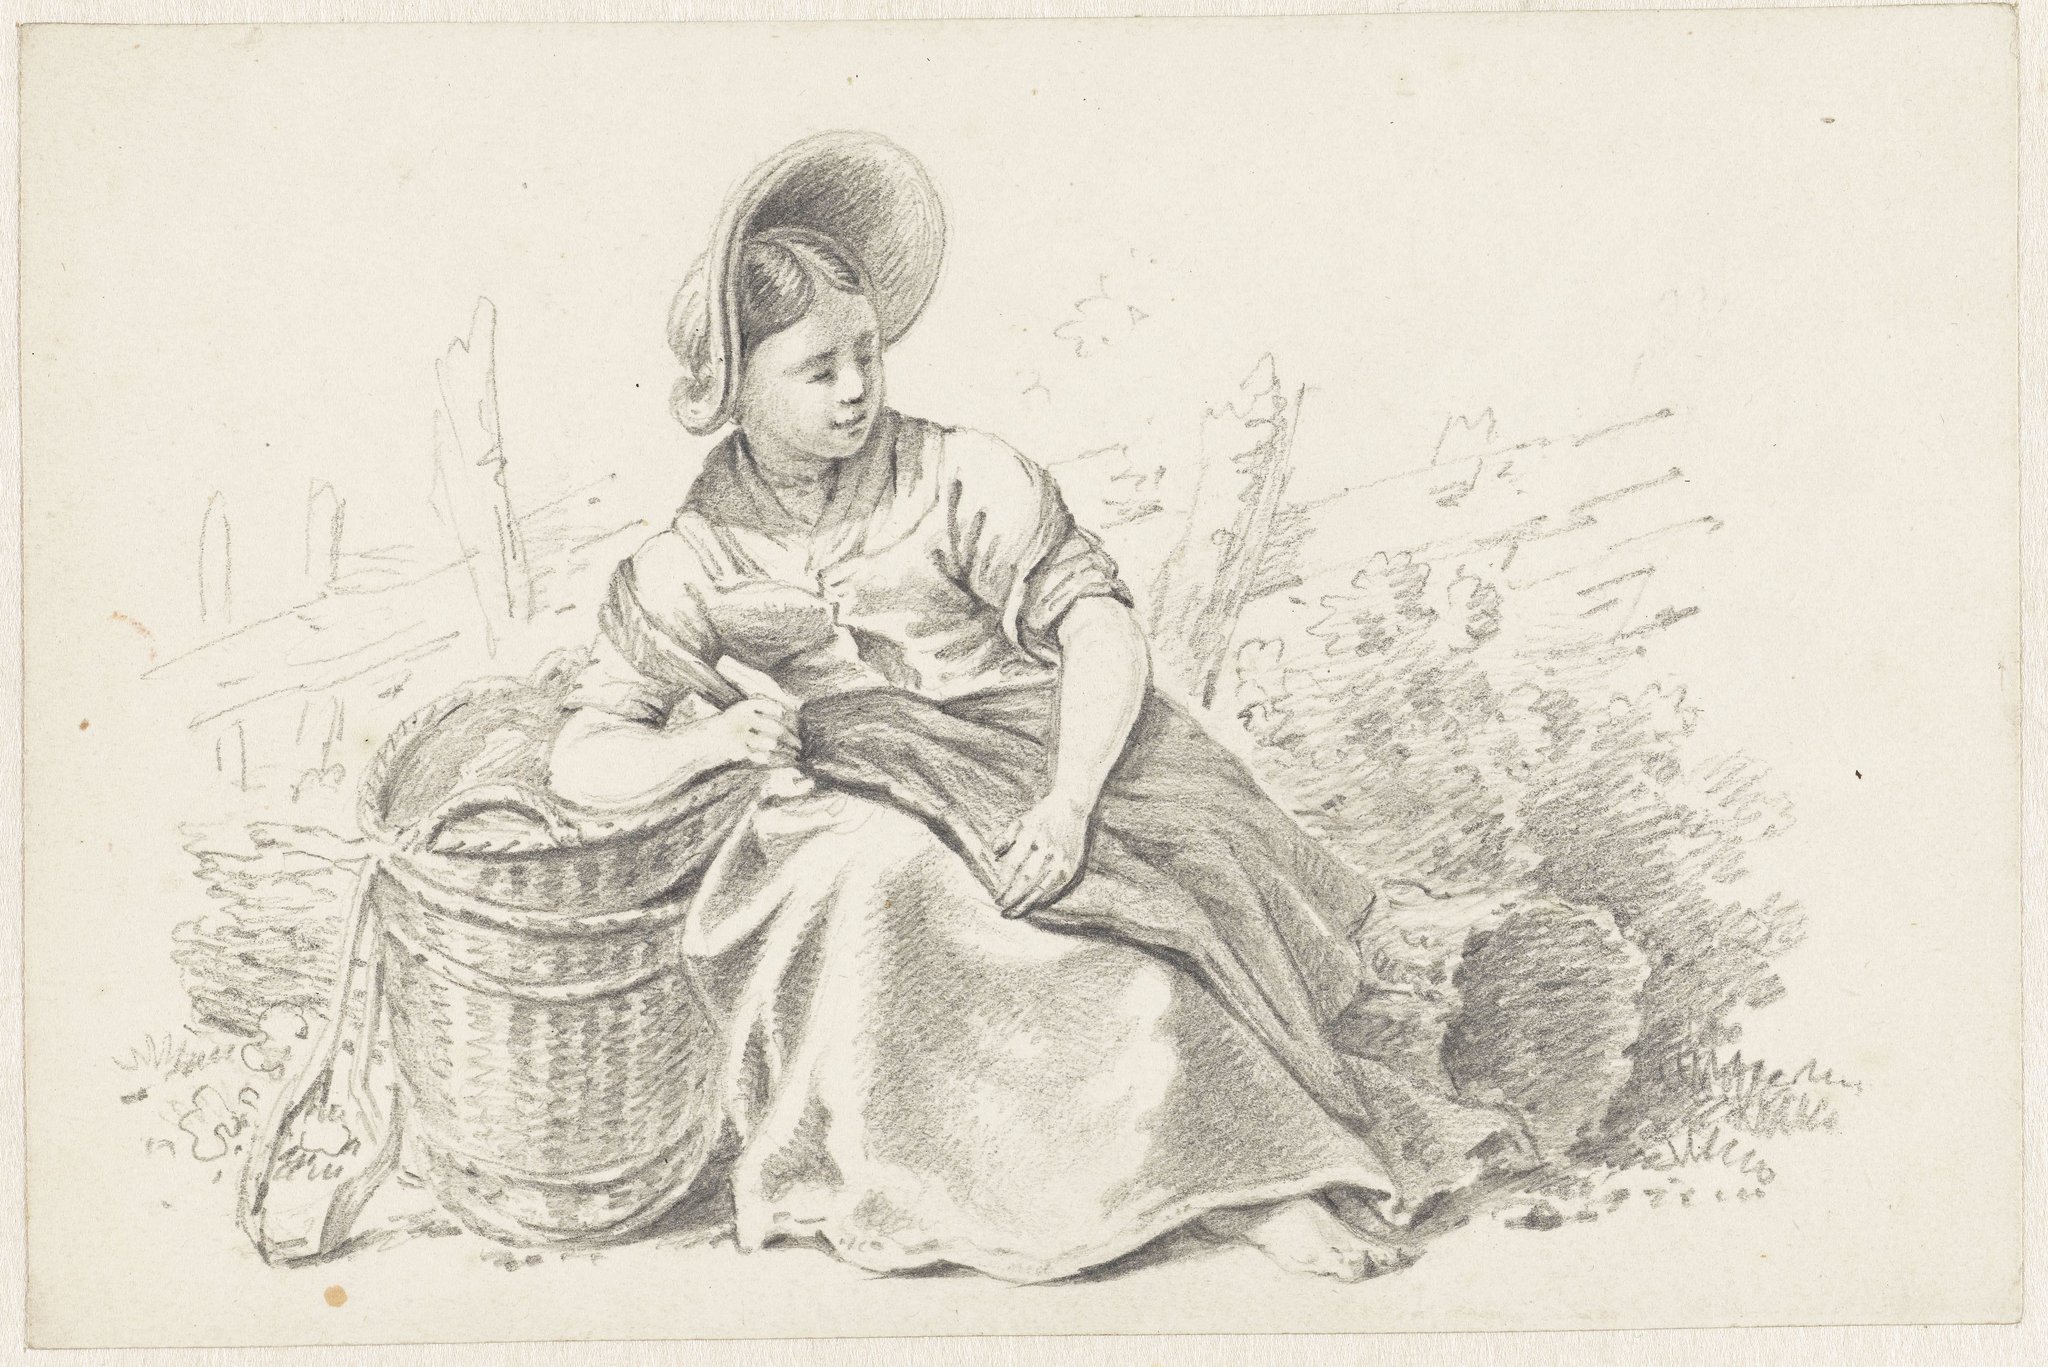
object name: drawing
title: Zittende, rustende vrouw met een mand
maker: pieter bartholomeusz. barbiers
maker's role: draughtsman, print maker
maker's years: 1772-1837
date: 1782-1837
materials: graphite, paper